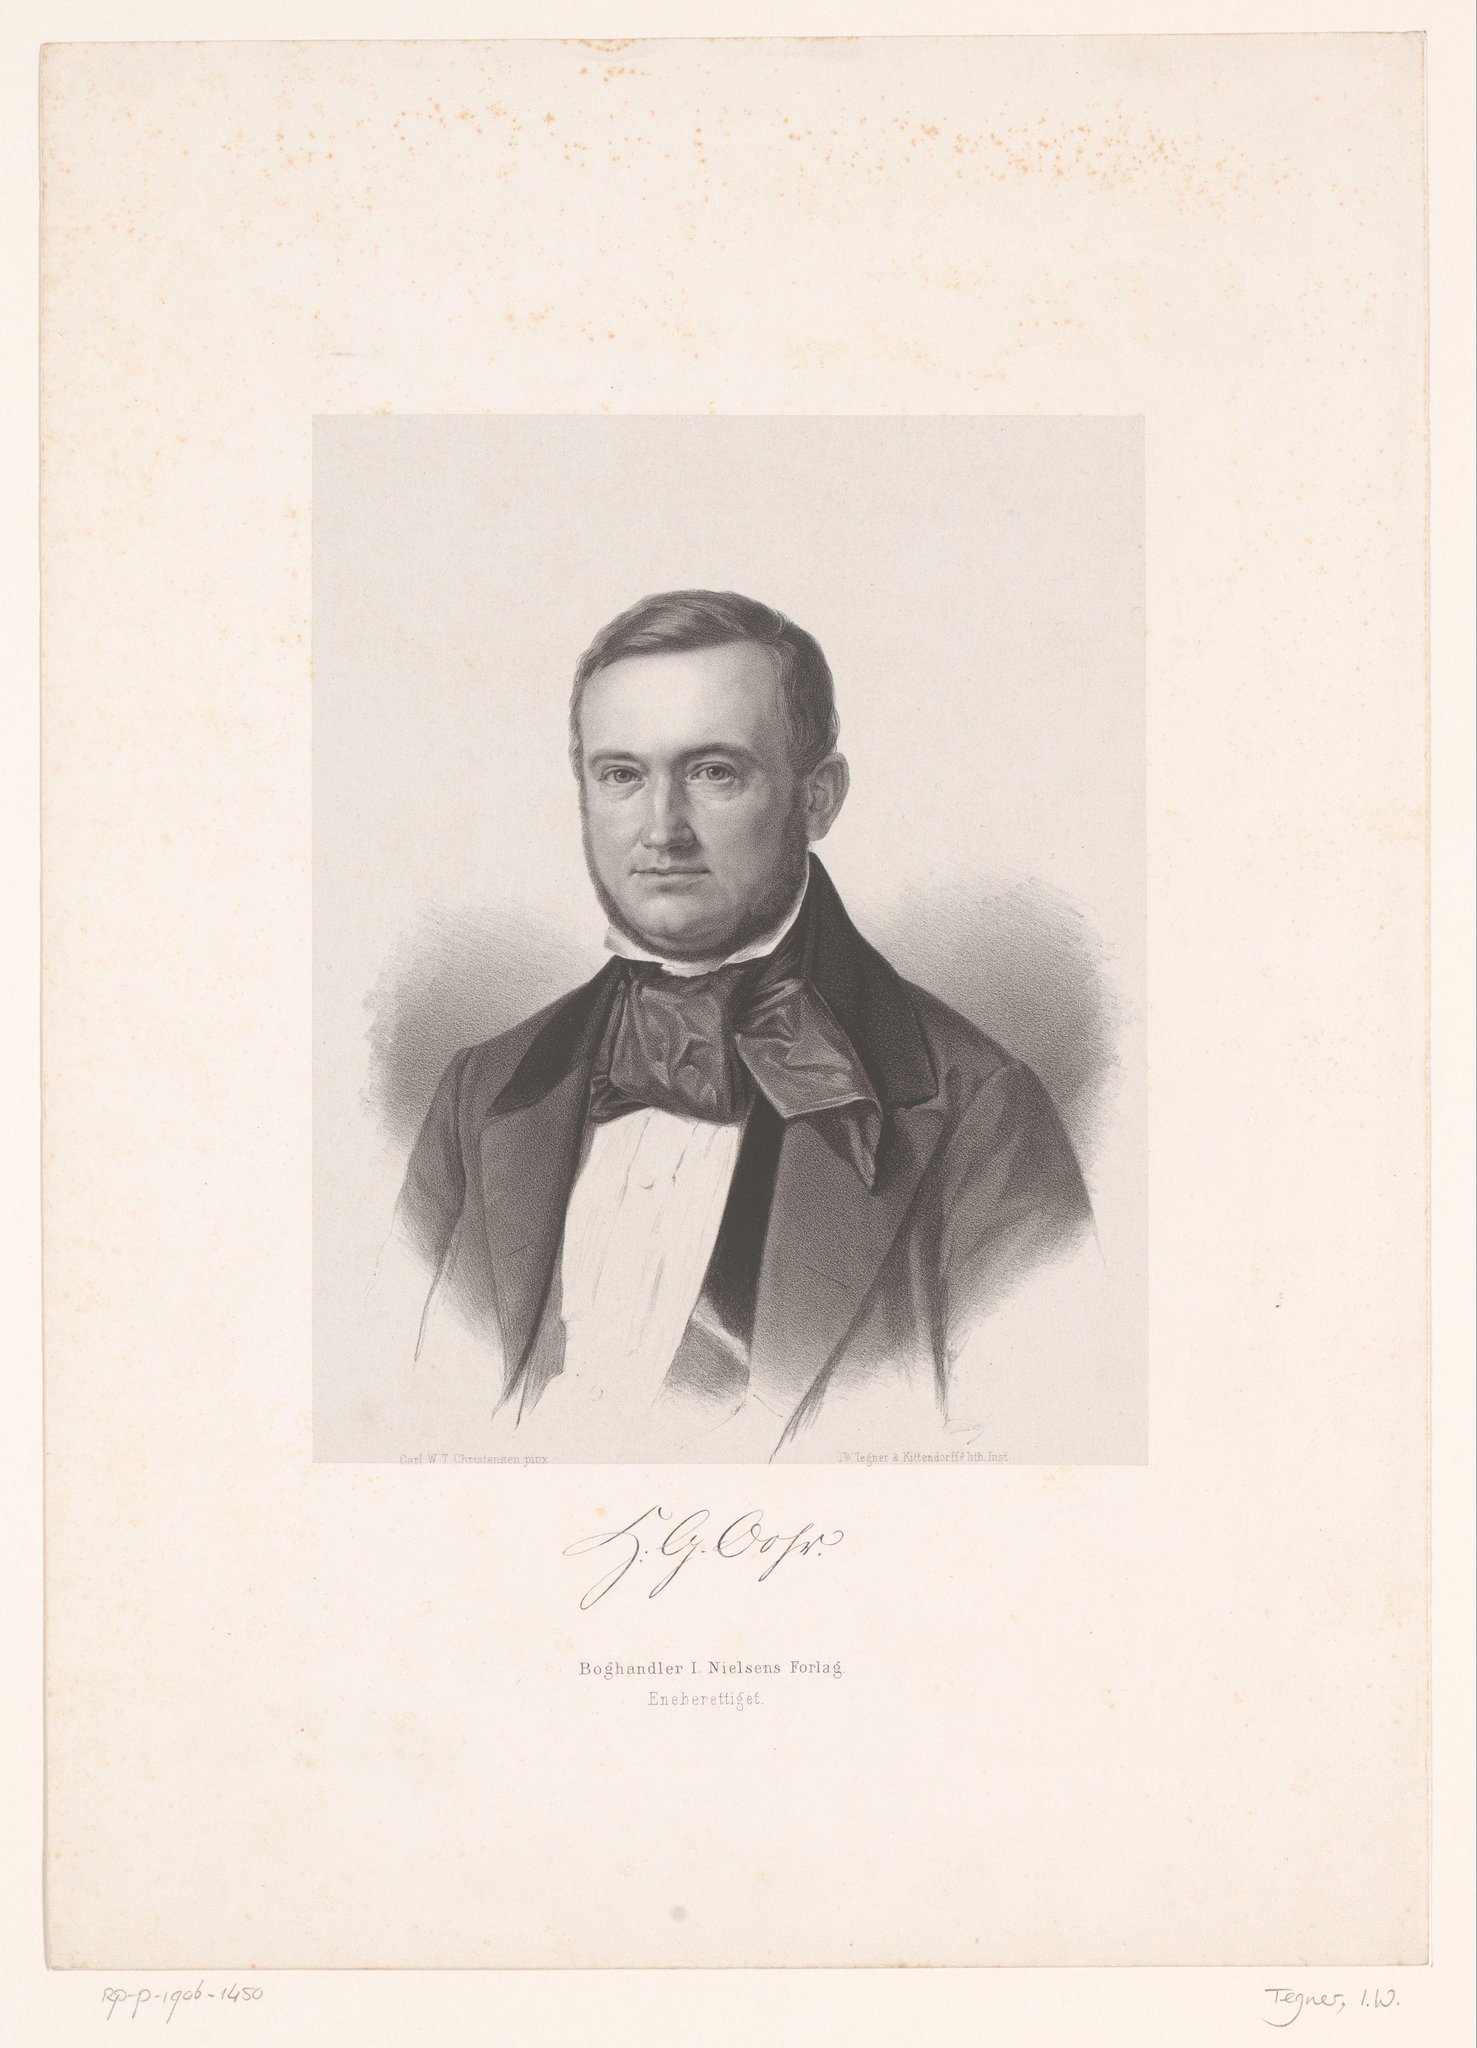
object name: print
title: Portret van een onbekende man, mogelijk H.G. Oofw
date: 1850-1893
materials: paper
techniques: lithograph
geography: copenhagen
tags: historical persons not known by name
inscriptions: collector's mark: Lugt 2228, inscription: ‘H. G. Oofw (?)’, signature: ‘J. W. Tegner & Kittendorff lith. Inst.’, signature: ‘Boghandler I. Nielsens Forlag. / Eneberettiget.’, signature: ‘Carl W. Christensen pinx’